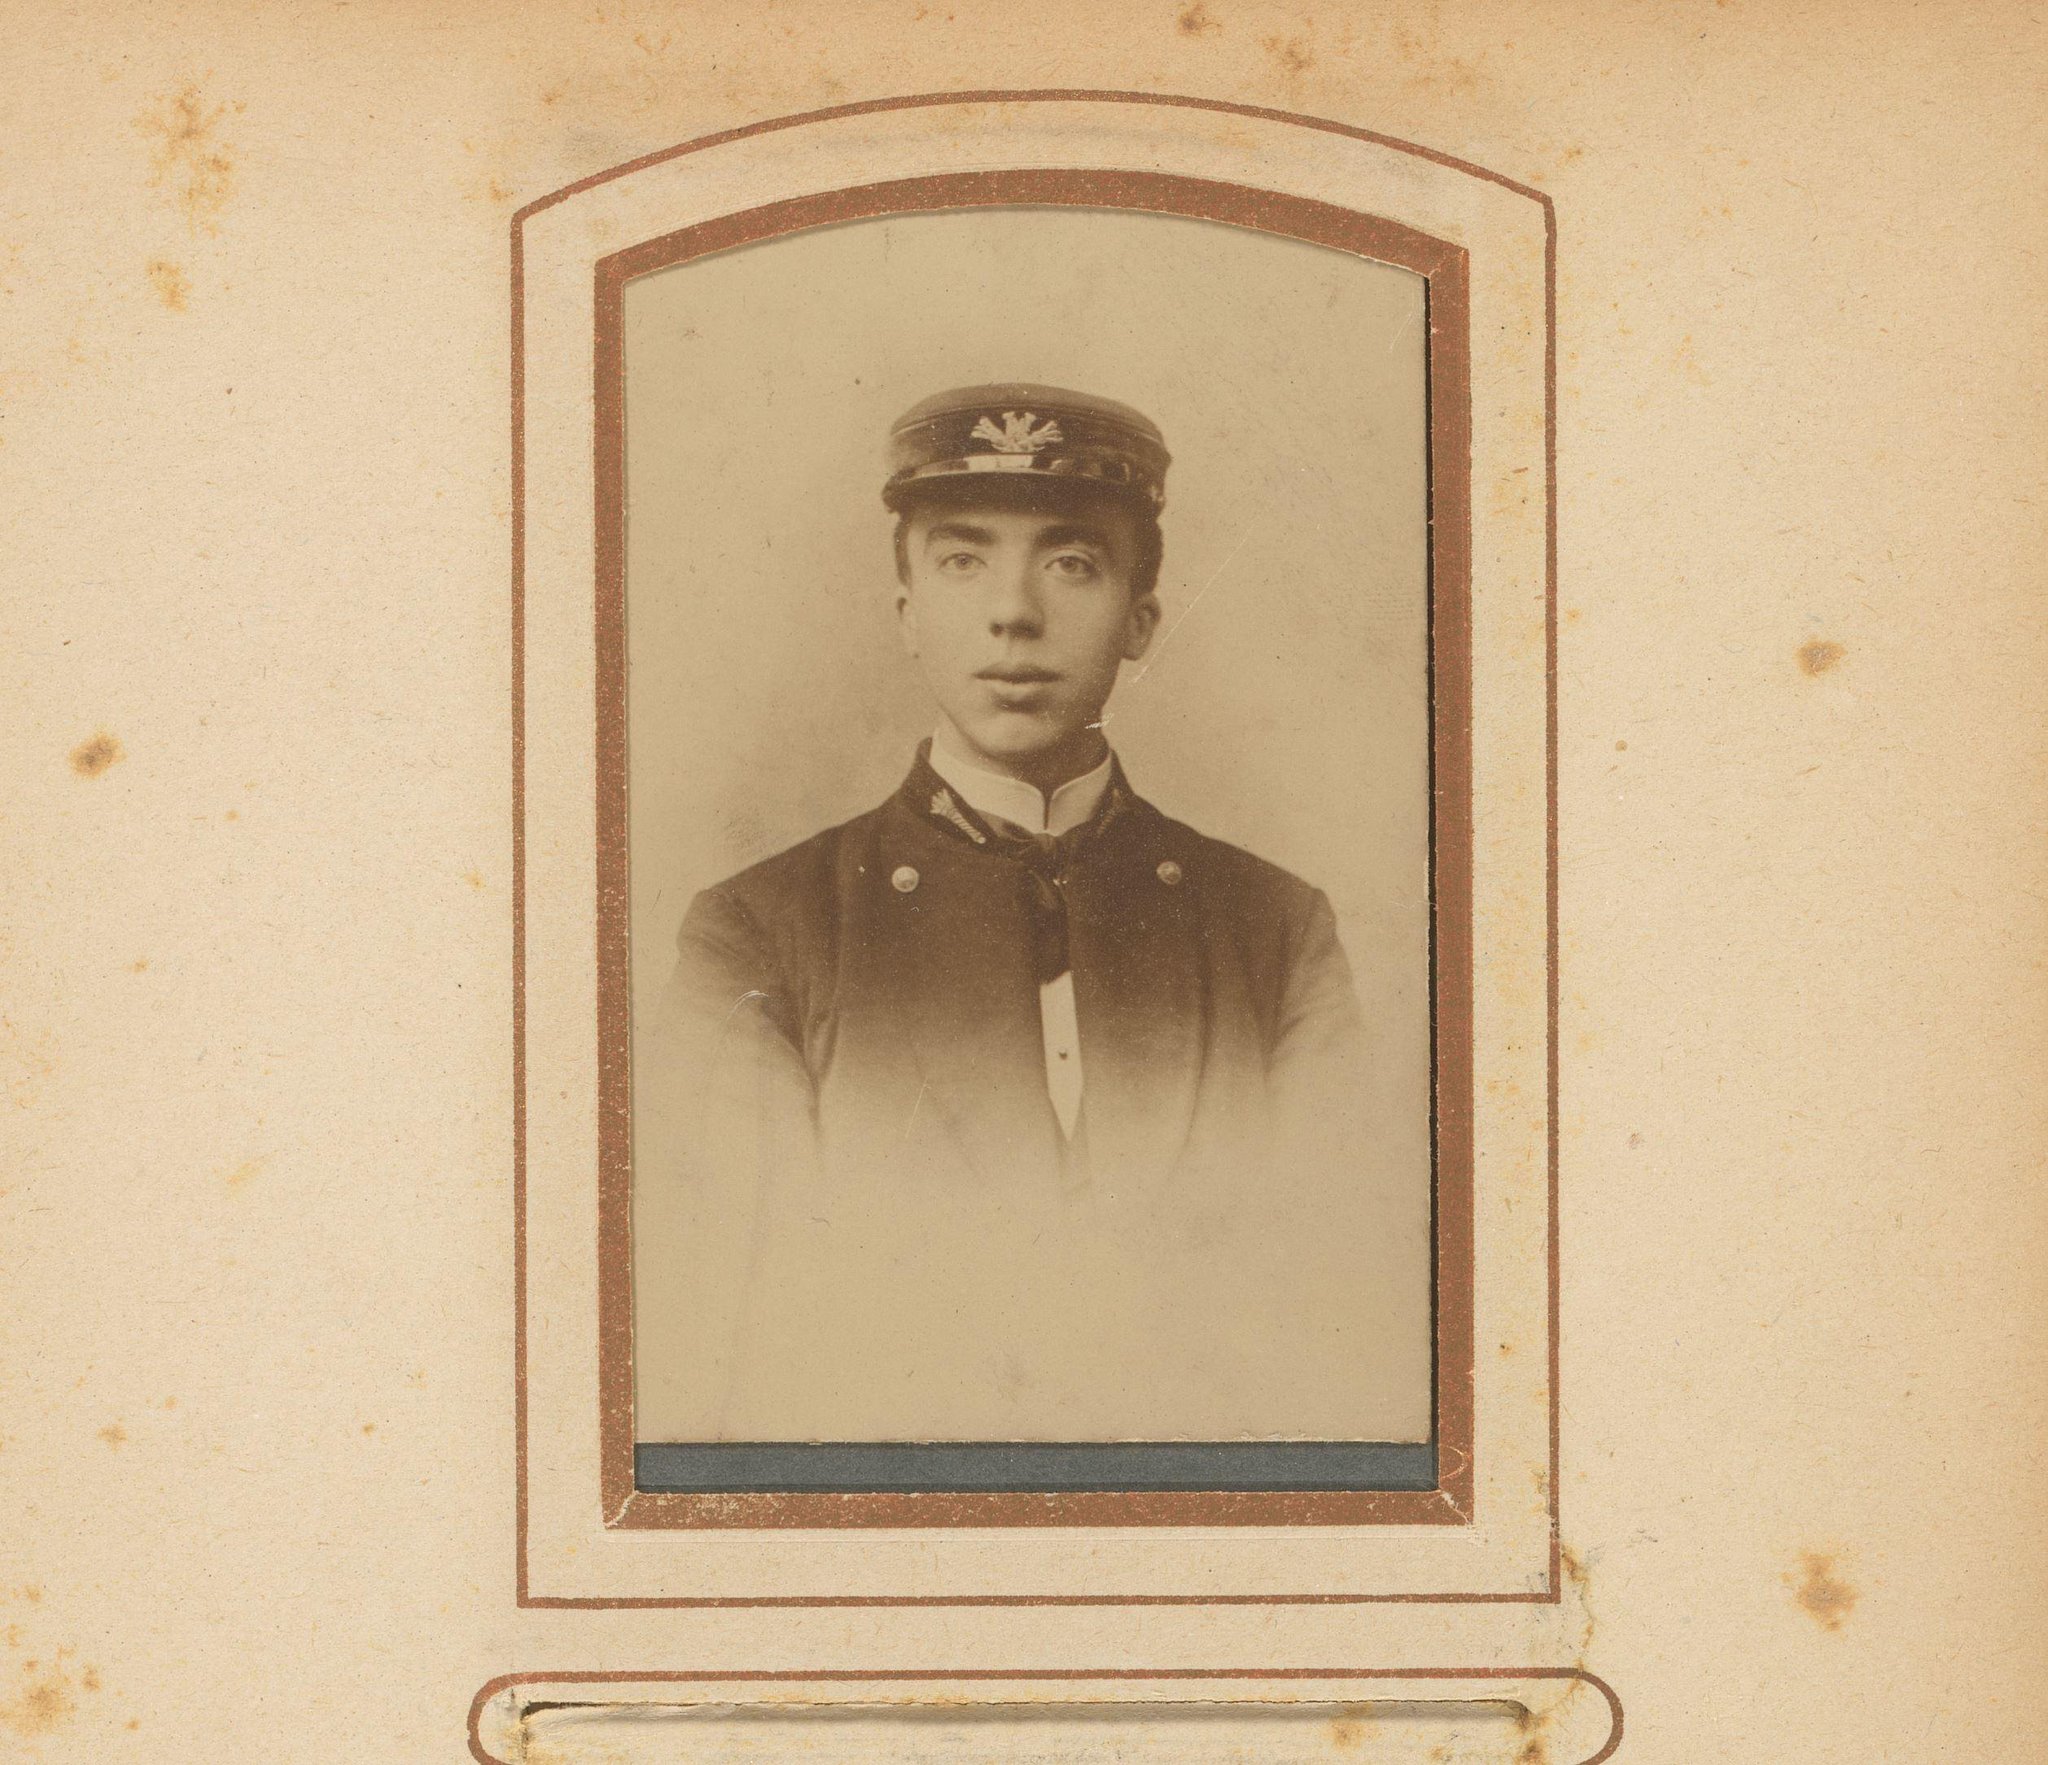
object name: carte de visite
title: Portret van een jongeman in uniform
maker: Anonymous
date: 1880-1910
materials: cardboard, photographic support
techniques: collodion silver print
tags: historical persons, youth, adolescent